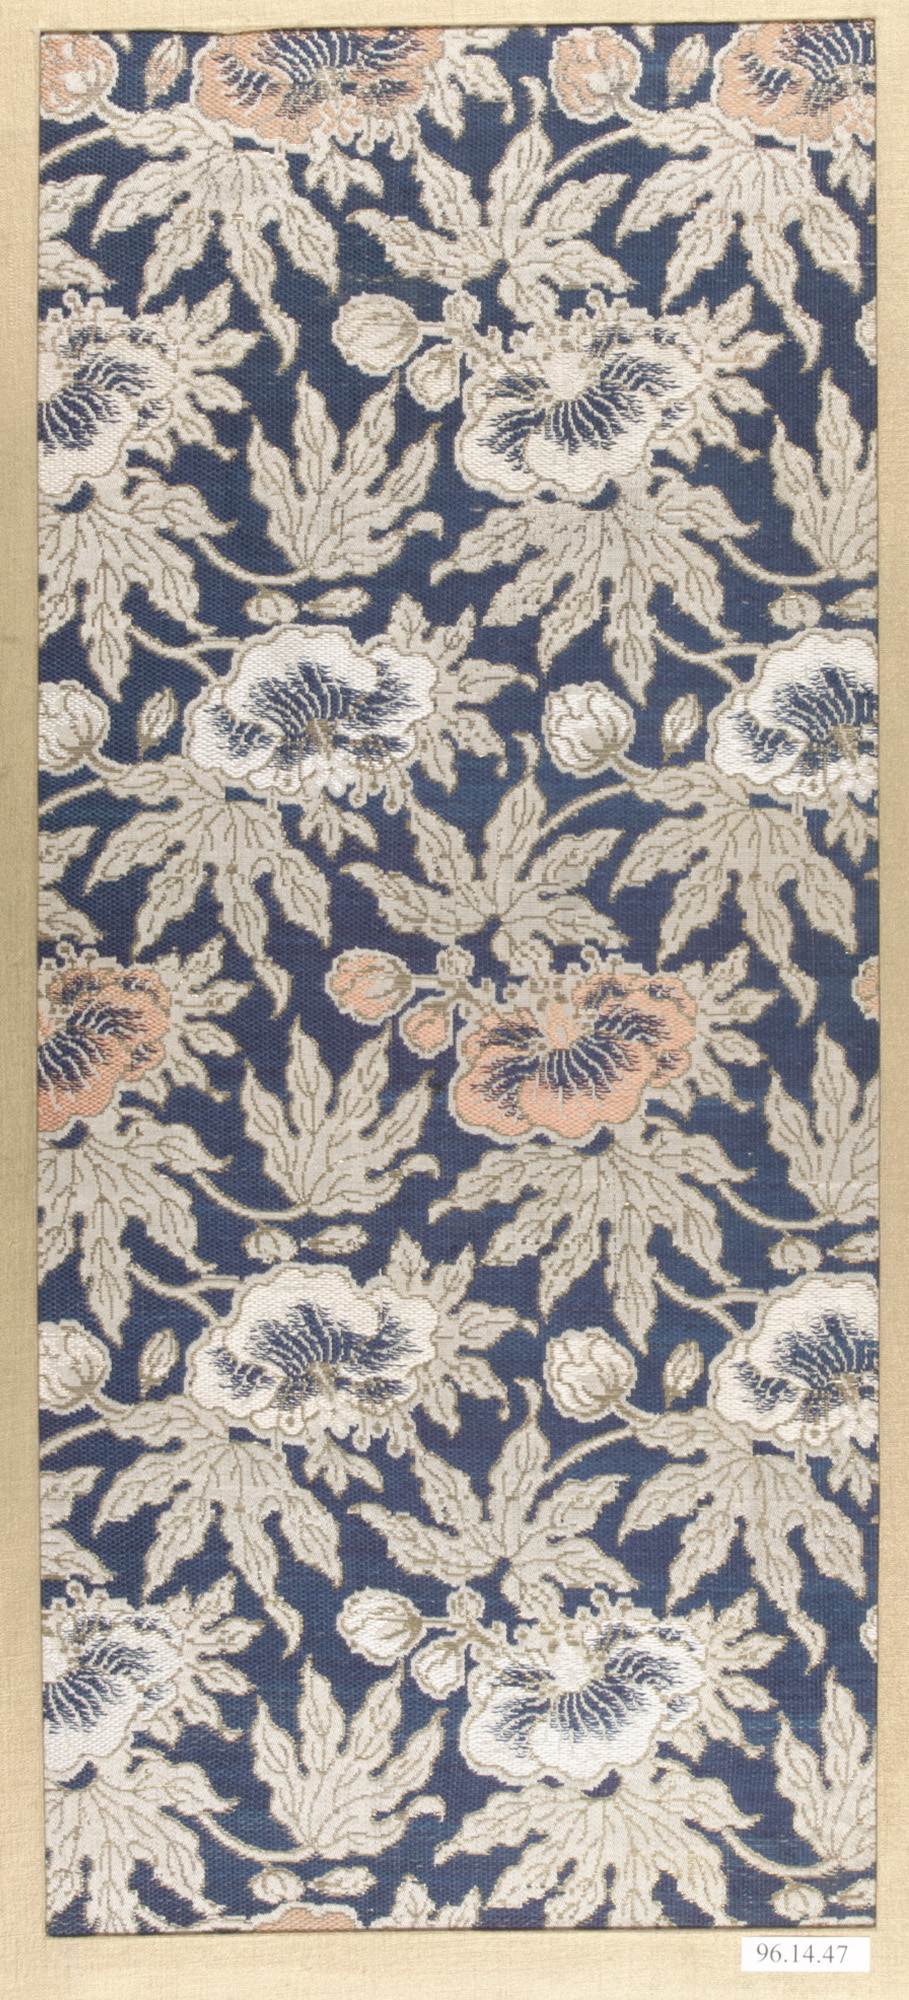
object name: piece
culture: japanese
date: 1701-1800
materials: silk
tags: leaves